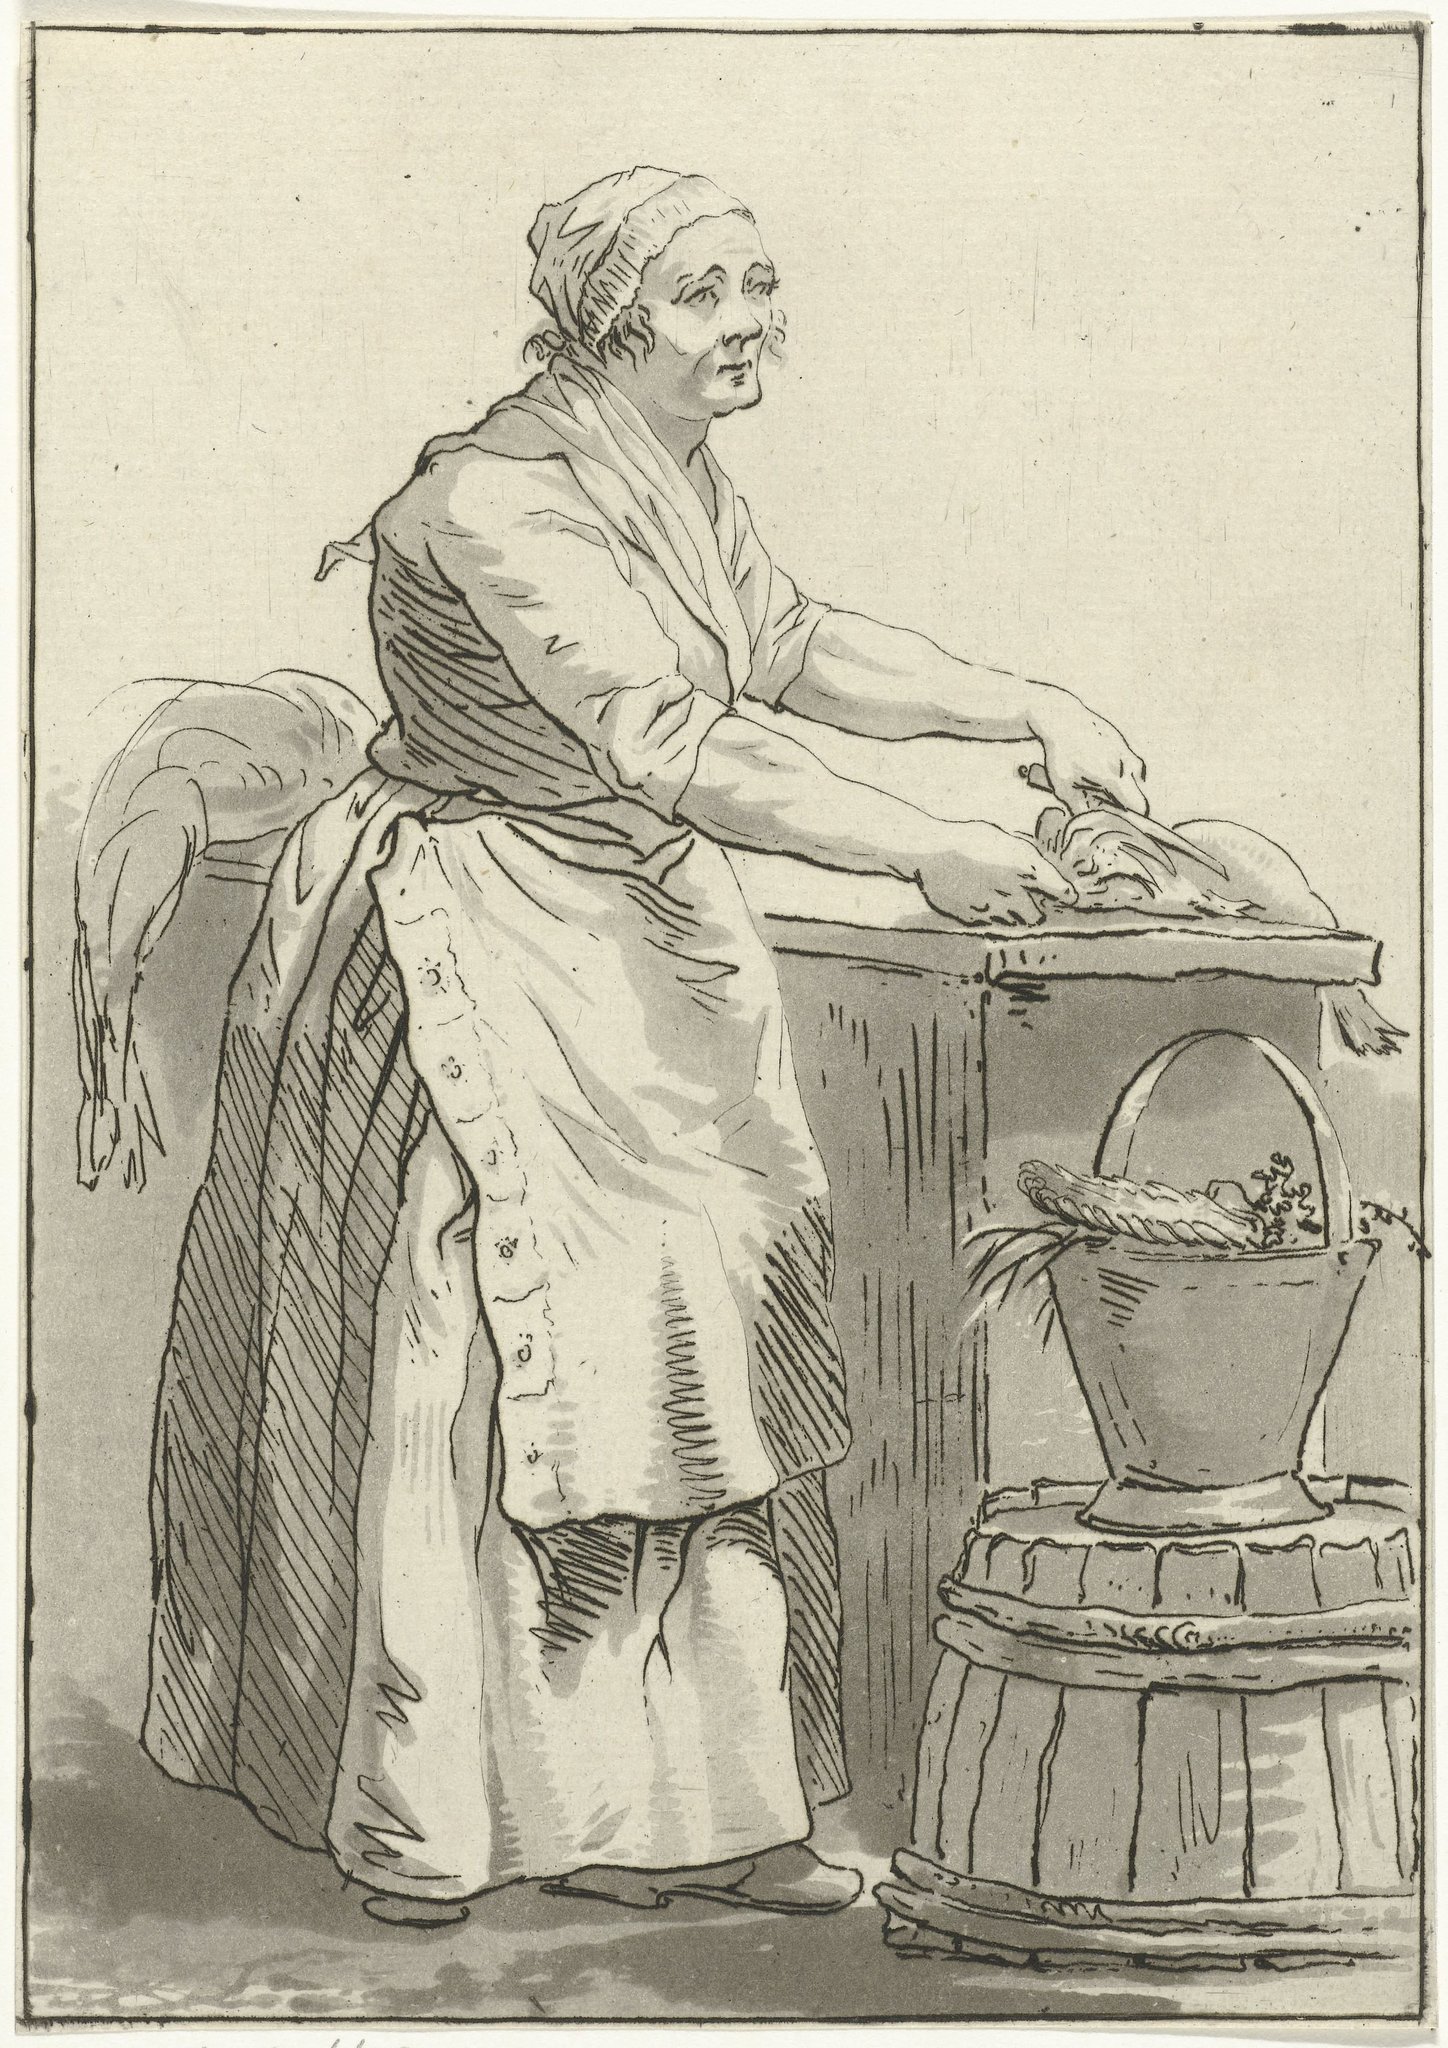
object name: print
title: Vis schoonmakende vrouw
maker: hermanus fock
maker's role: conservator, draughtsman, painter, print maker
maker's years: 1766-1822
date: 1781-1822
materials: paper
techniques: aquatint, etching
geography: amsterdam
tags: commercial fishery (+ preparing for use or consumption ~ crafts, industries, agriculture)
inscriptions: collector's mark: Lugt 2228